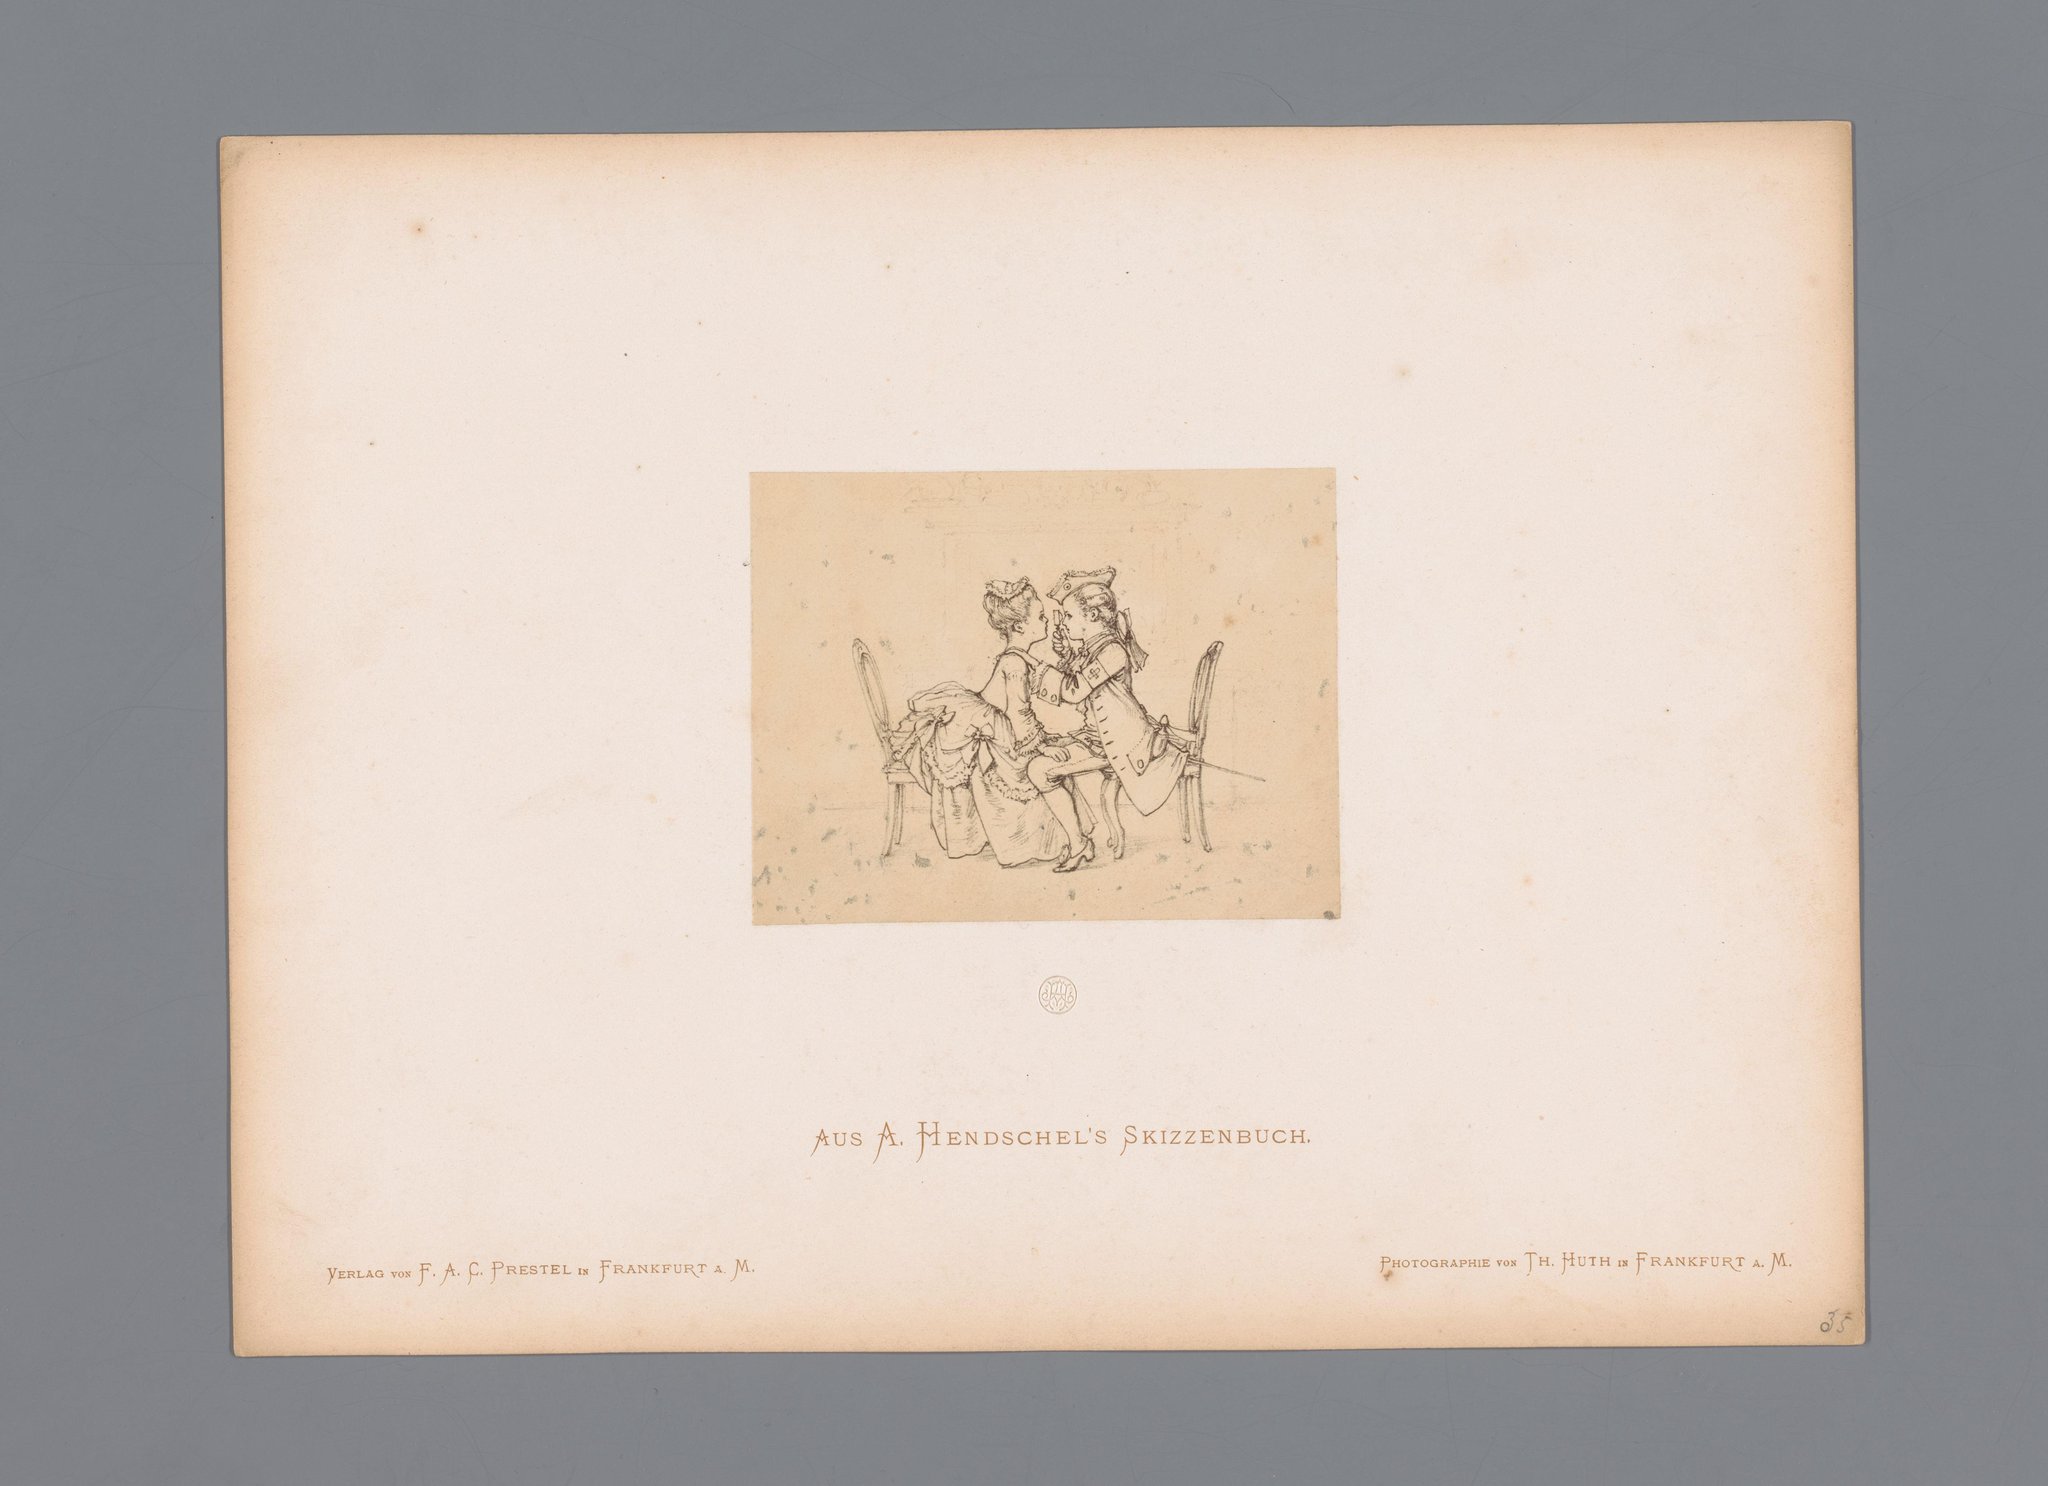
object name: reproduction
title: Fotoreproductie van een schets van twee kinderen die een bezoek aan de oogarts naspelen, door Albert Hendschel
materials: photographic support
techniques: albumen print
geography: frankfurt am main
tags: children's games and plays, child (+ two persons)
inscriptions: number: ‘35’, monogram: ‘AH’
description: Deze foto maakt deel uit van een omslag met 50 foto's op 48 bladen, een lijst van afbeeldingen en een titelblad.